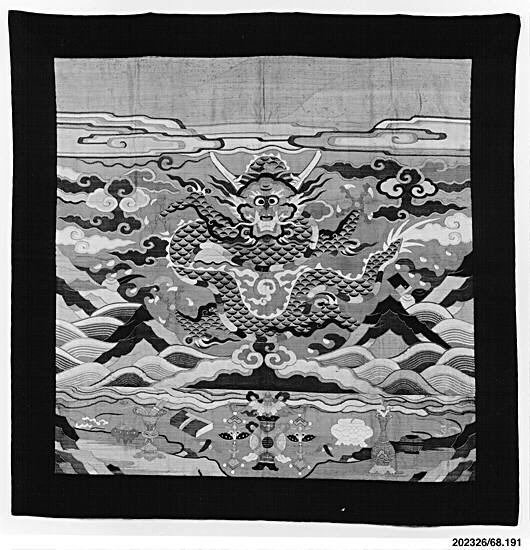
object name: valance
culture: chinese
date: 1601-1700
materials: metal thread, silk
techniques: tapestry, weave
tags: dragons